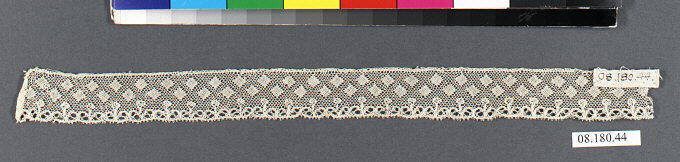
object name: piece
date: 1801-1833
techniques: lace